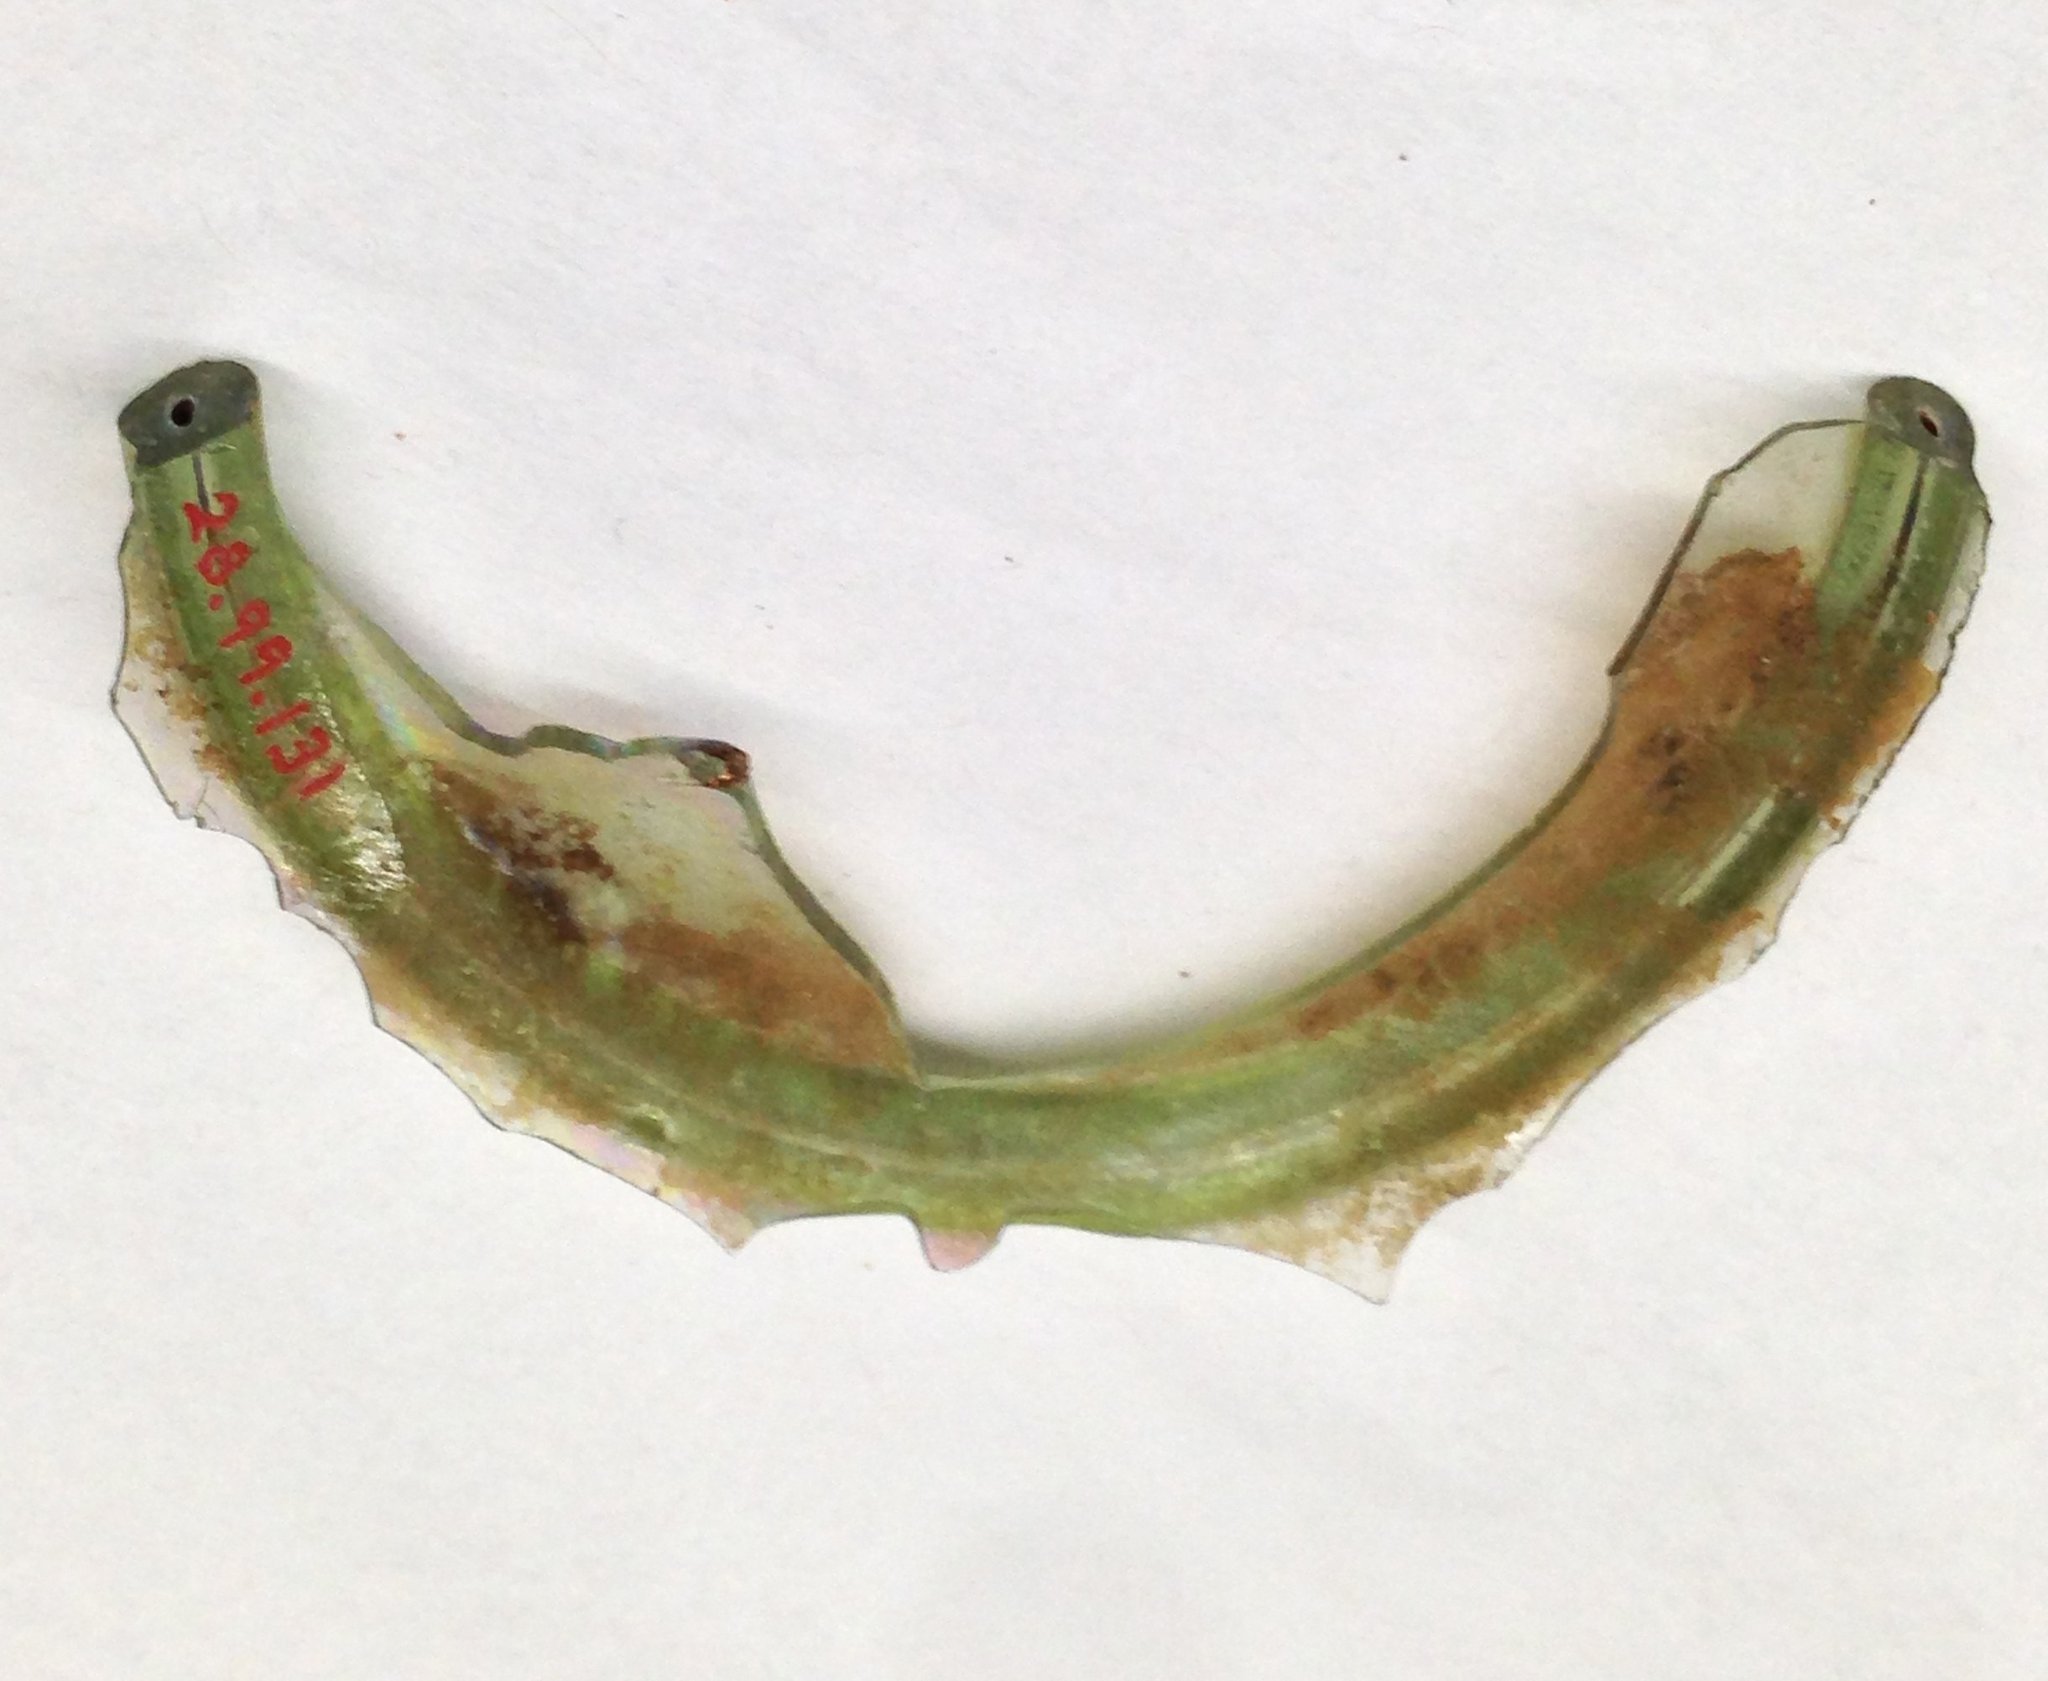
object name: fragment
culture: european or middle eastern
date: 1150-1250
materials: ceramic, glass